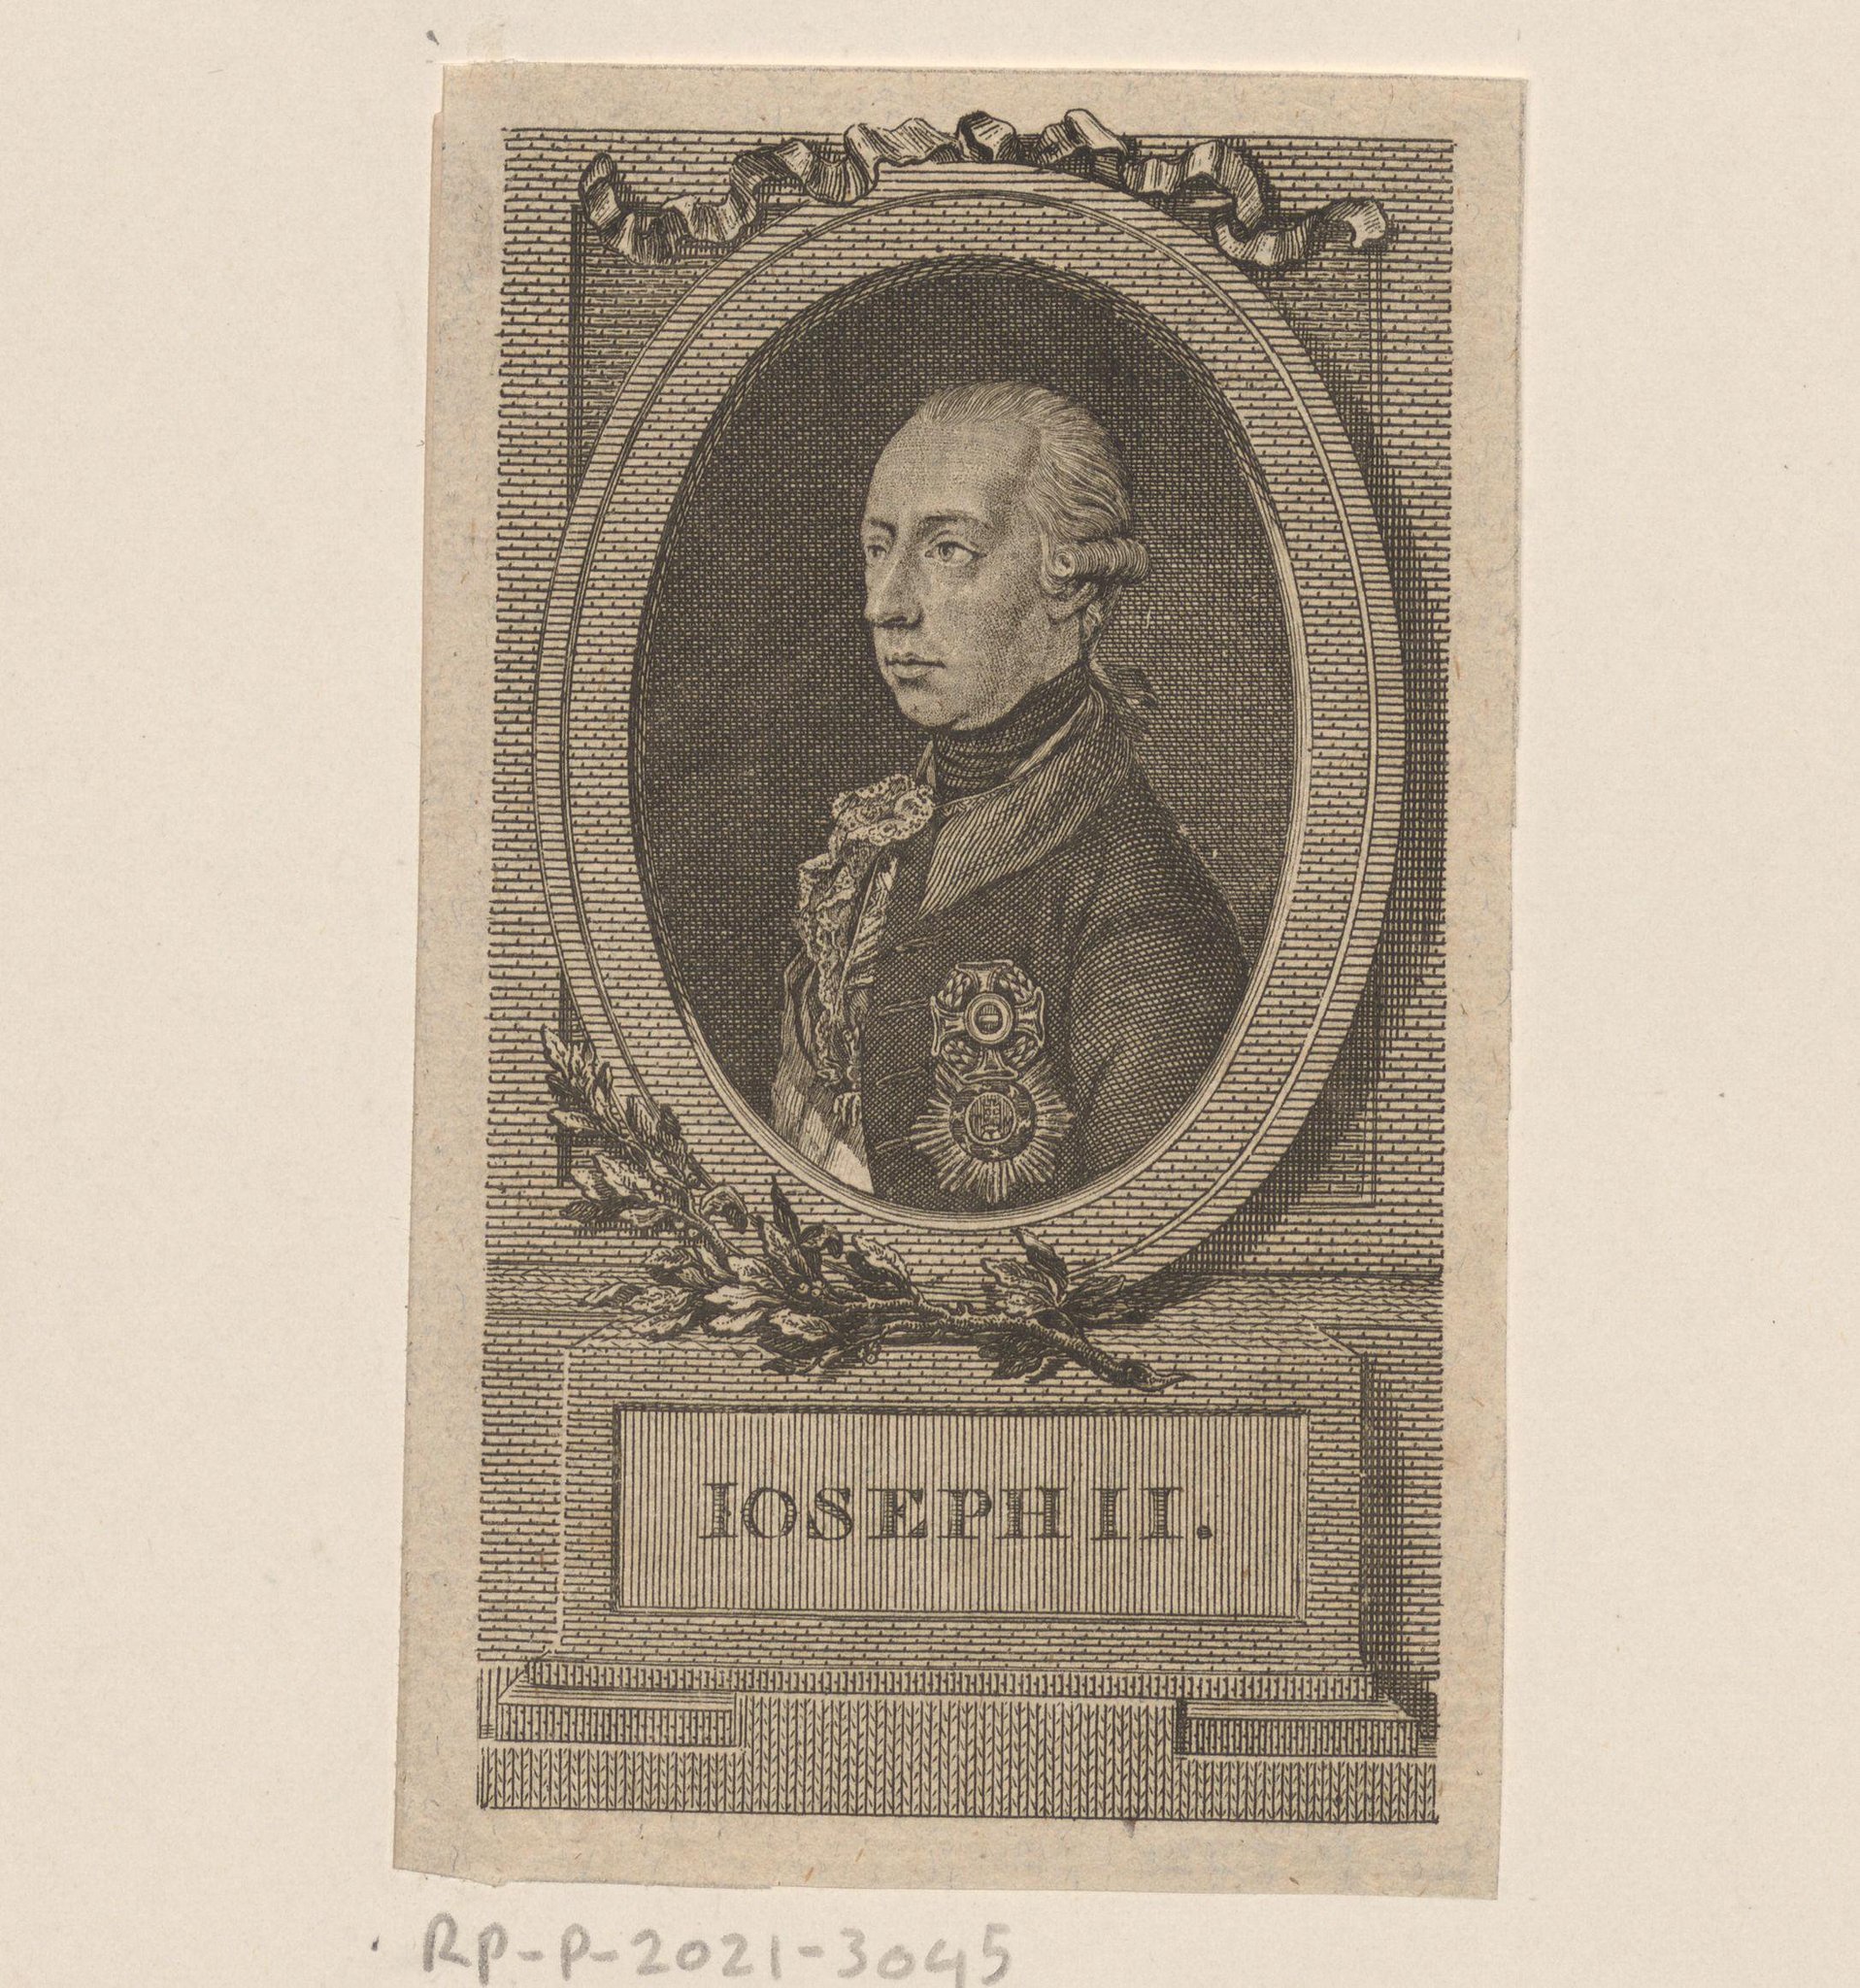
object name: print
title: Portret van Jozef II, Duits keizer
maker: Anonymous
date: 1765-1799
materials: paper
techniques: engraving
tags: jozef ii (duits keizer), knighthood order, historical persons, emperor